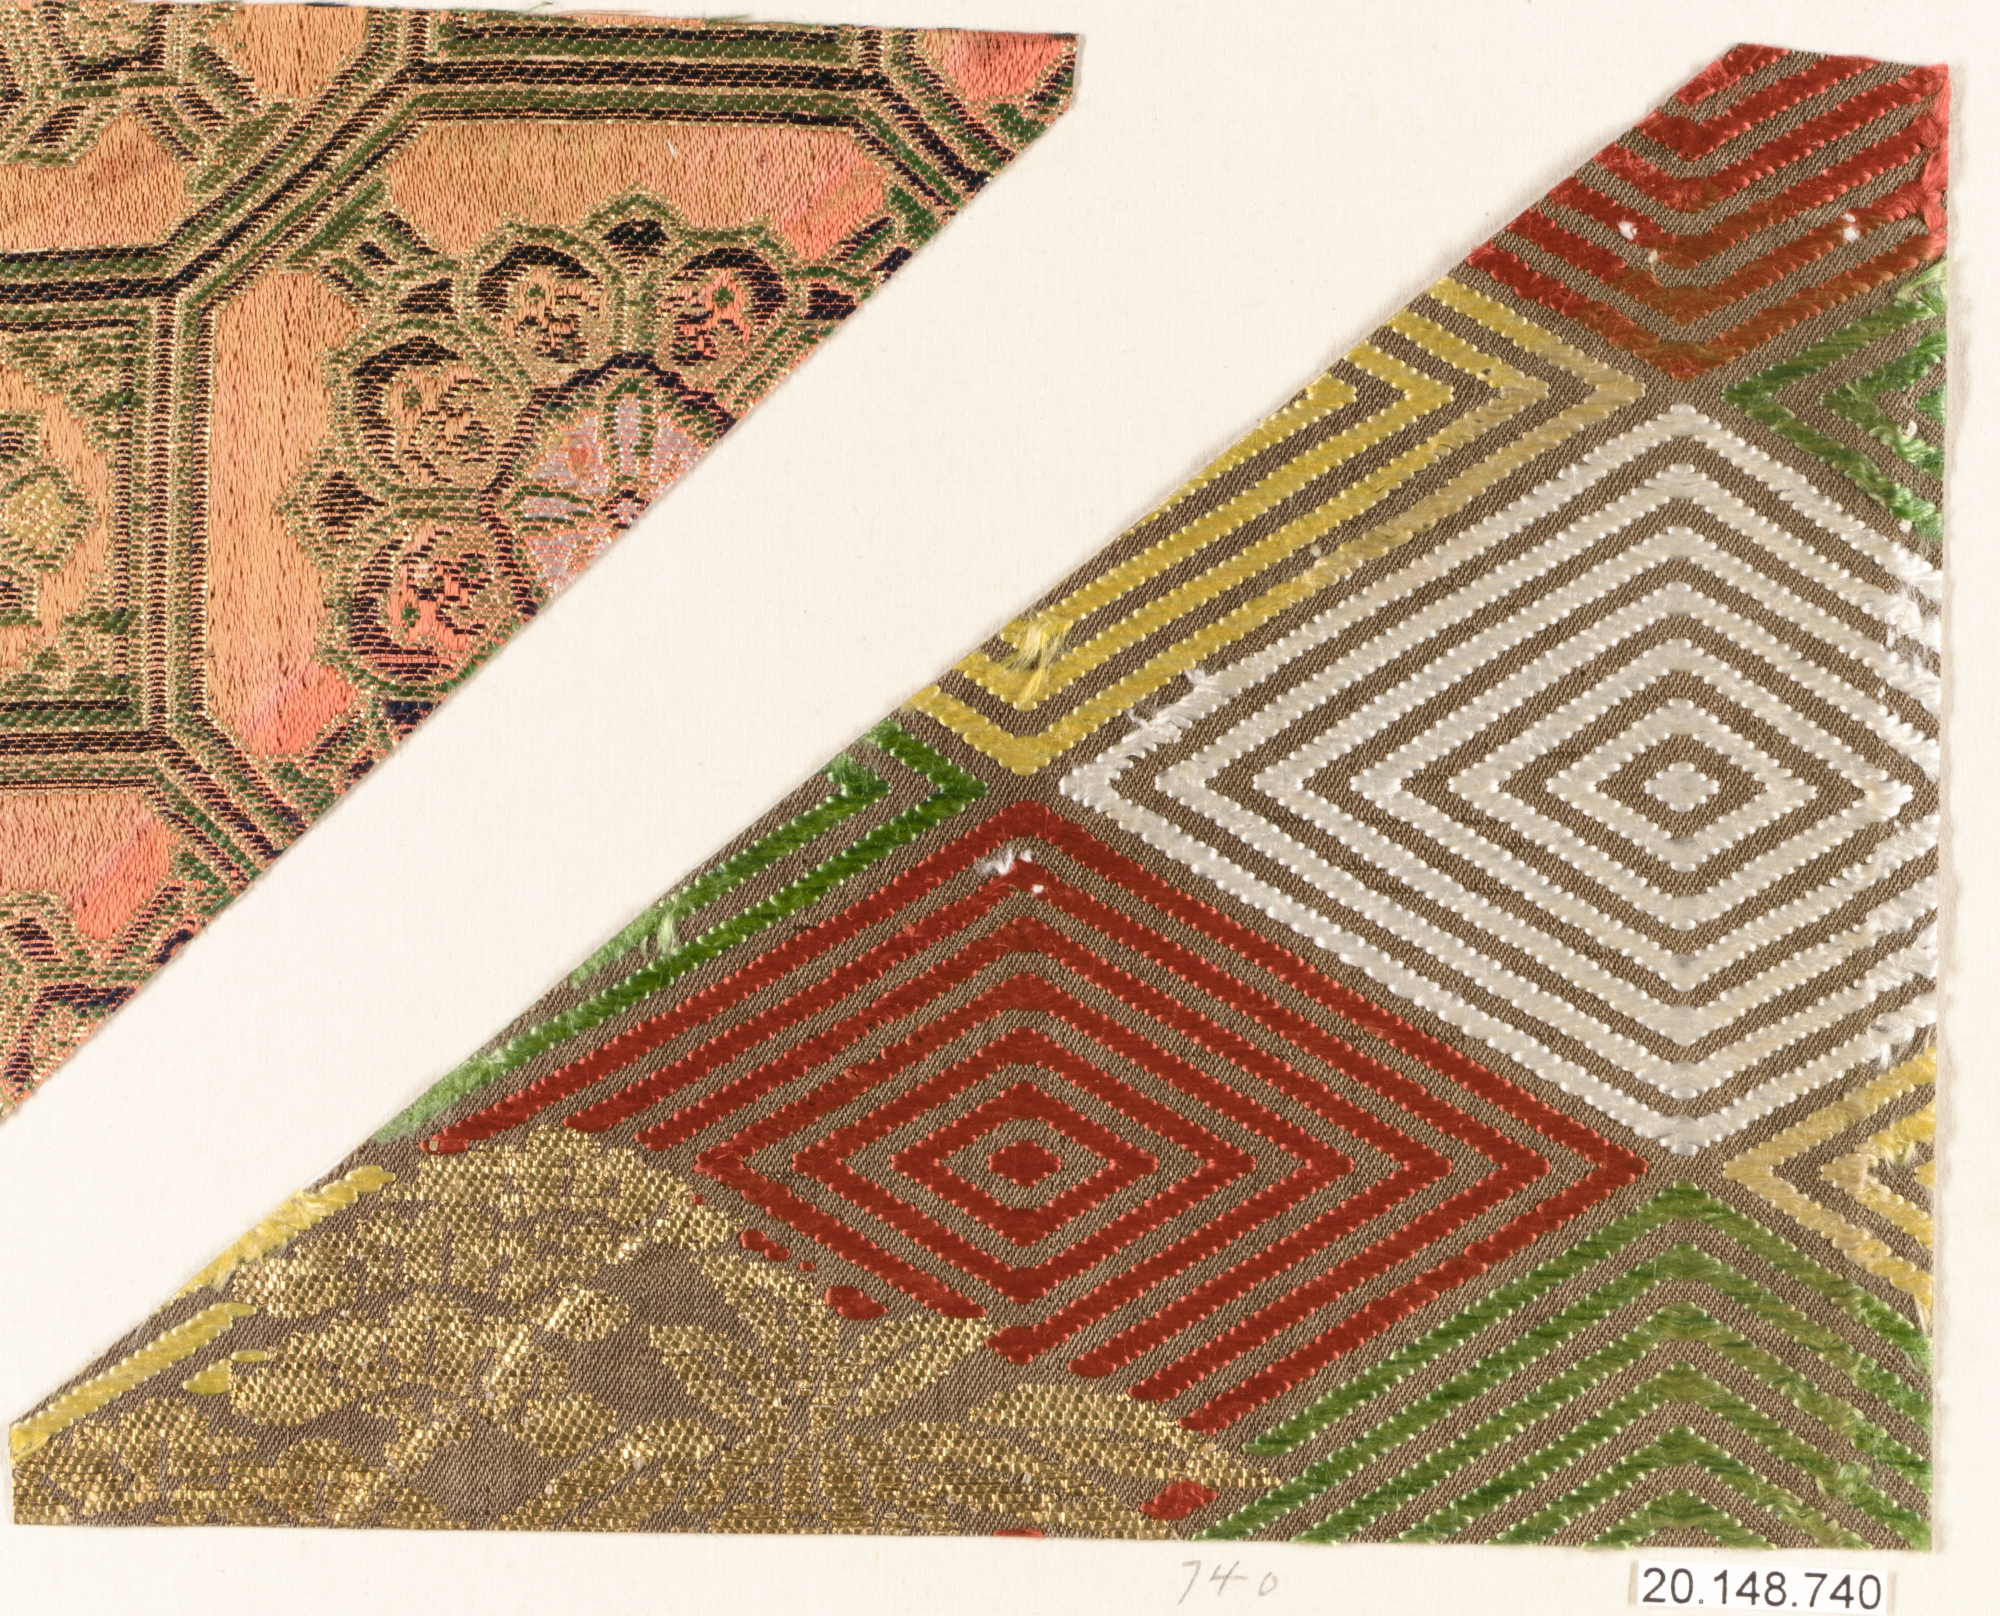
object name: piece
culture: japanese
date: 1601-1700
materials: silk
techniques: compound weave